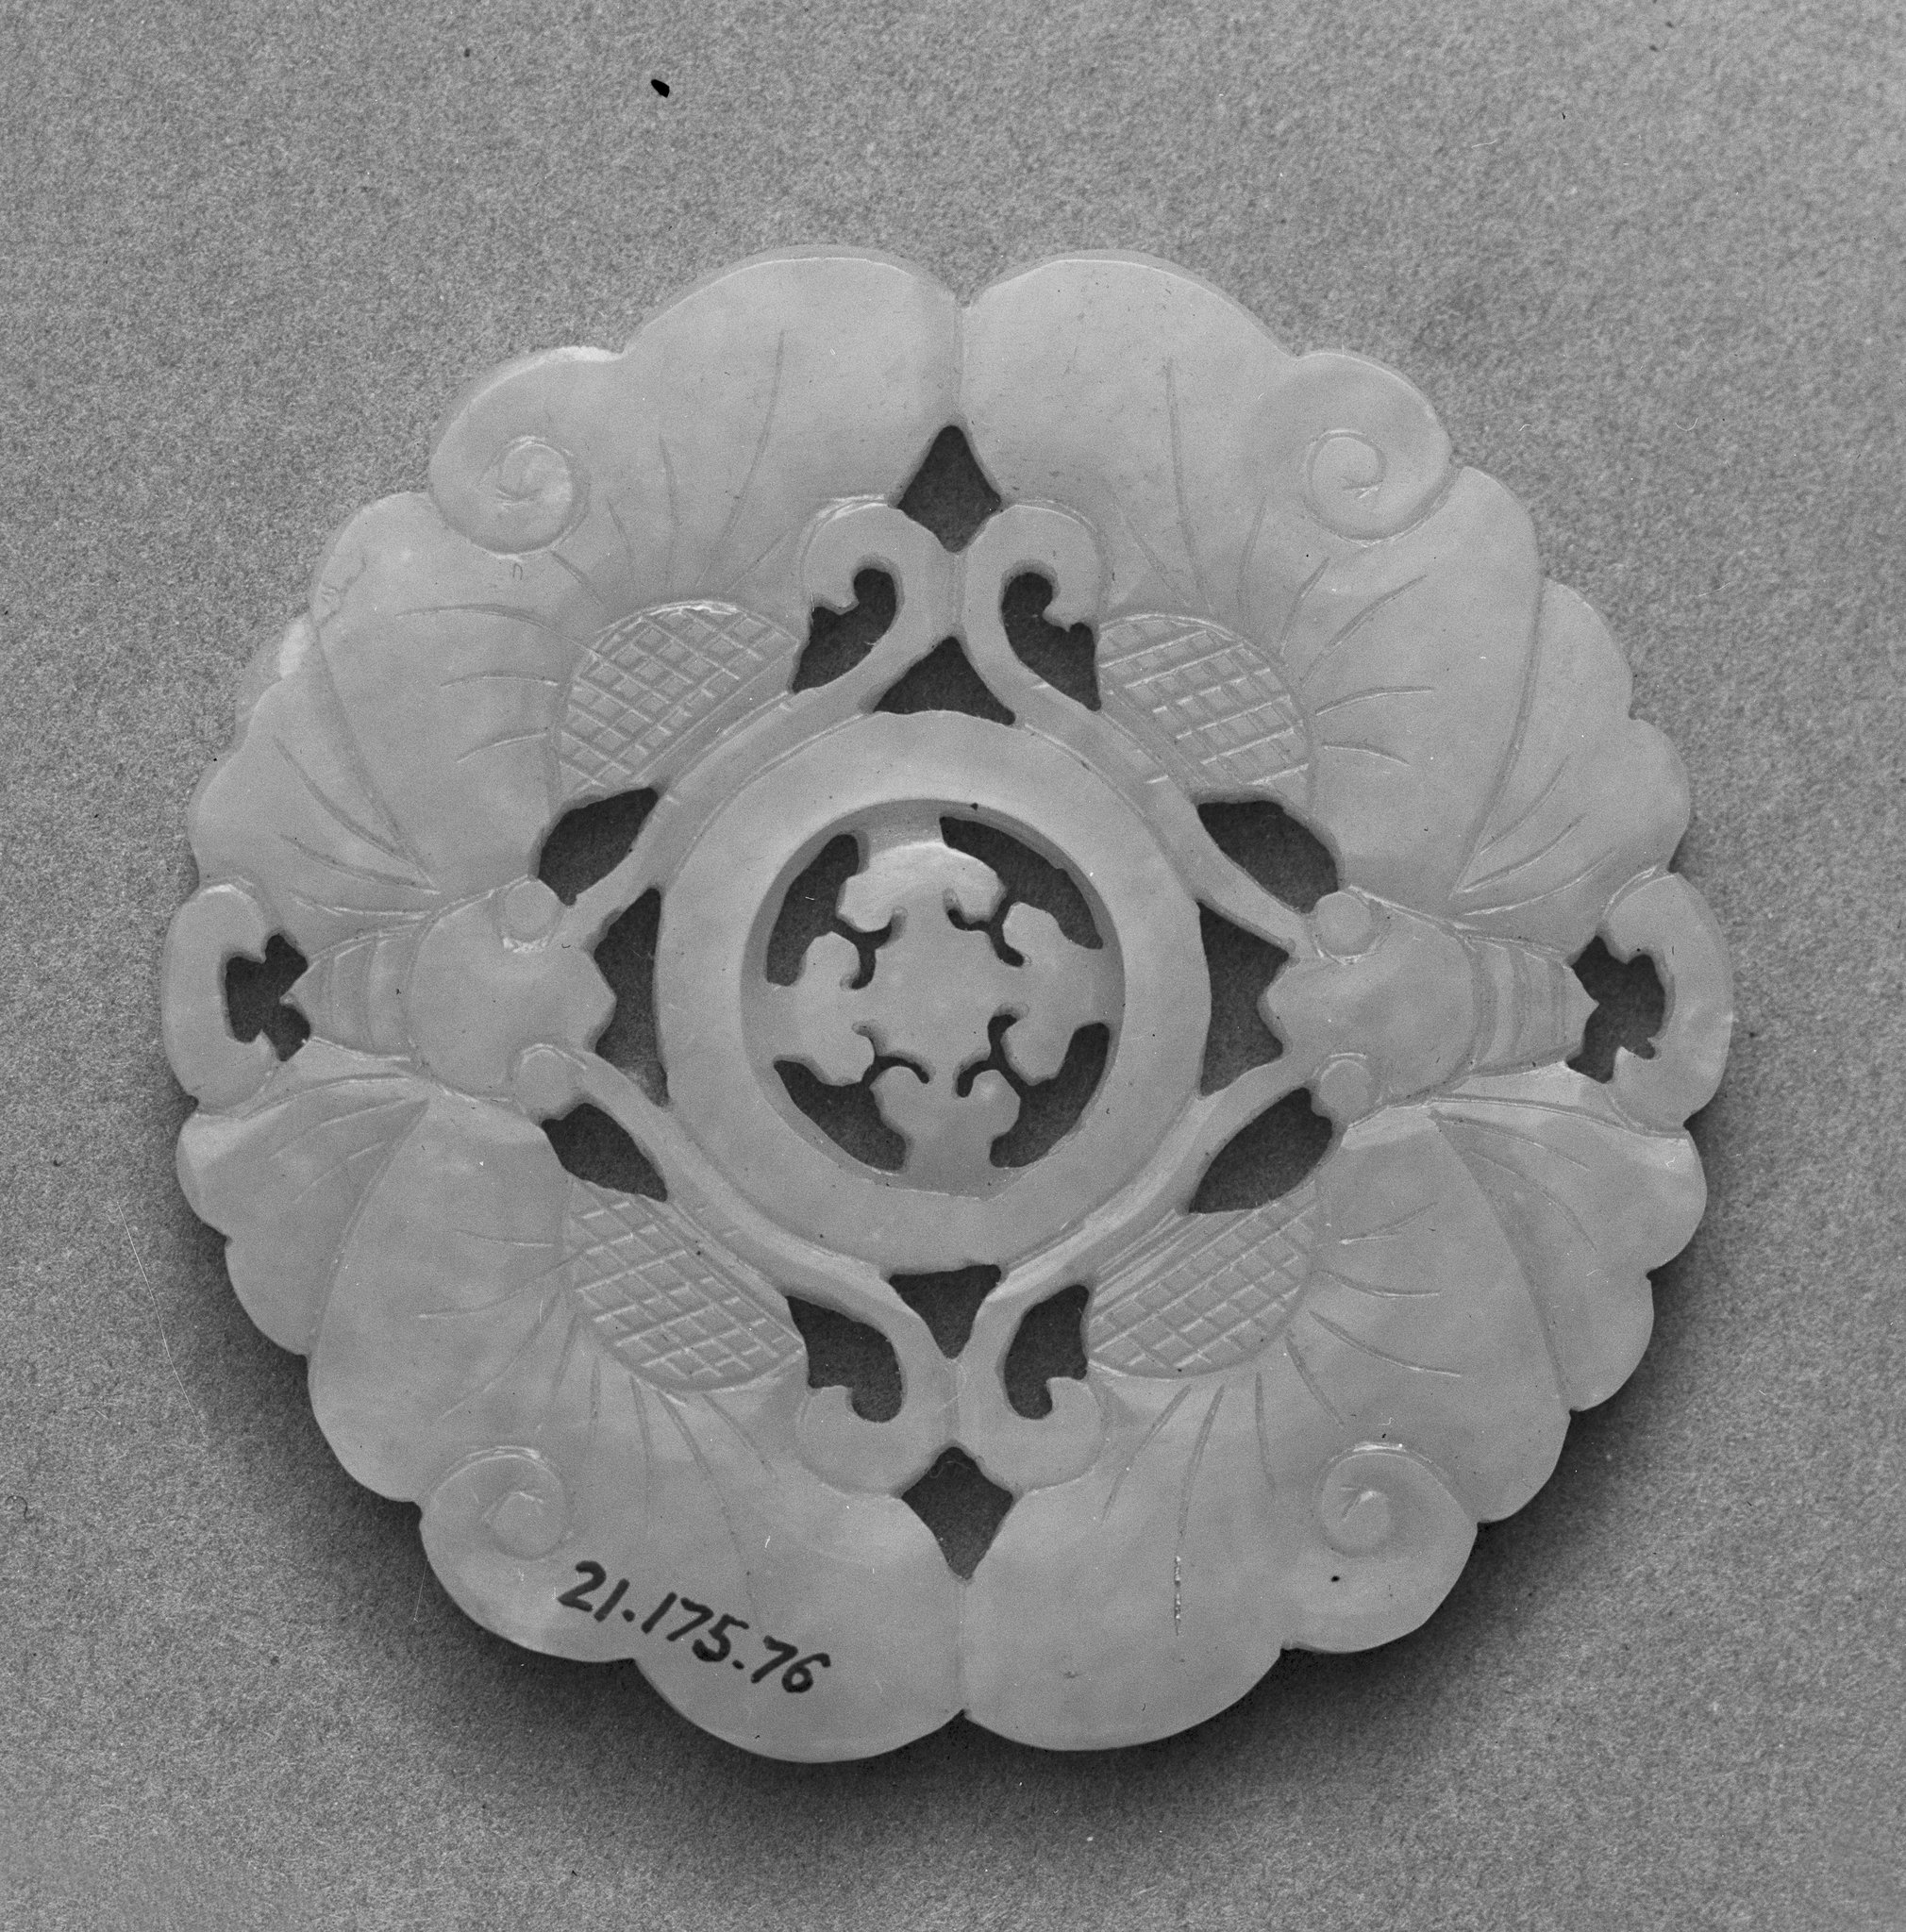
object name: disk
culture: chinese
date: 1801-1900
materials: jade